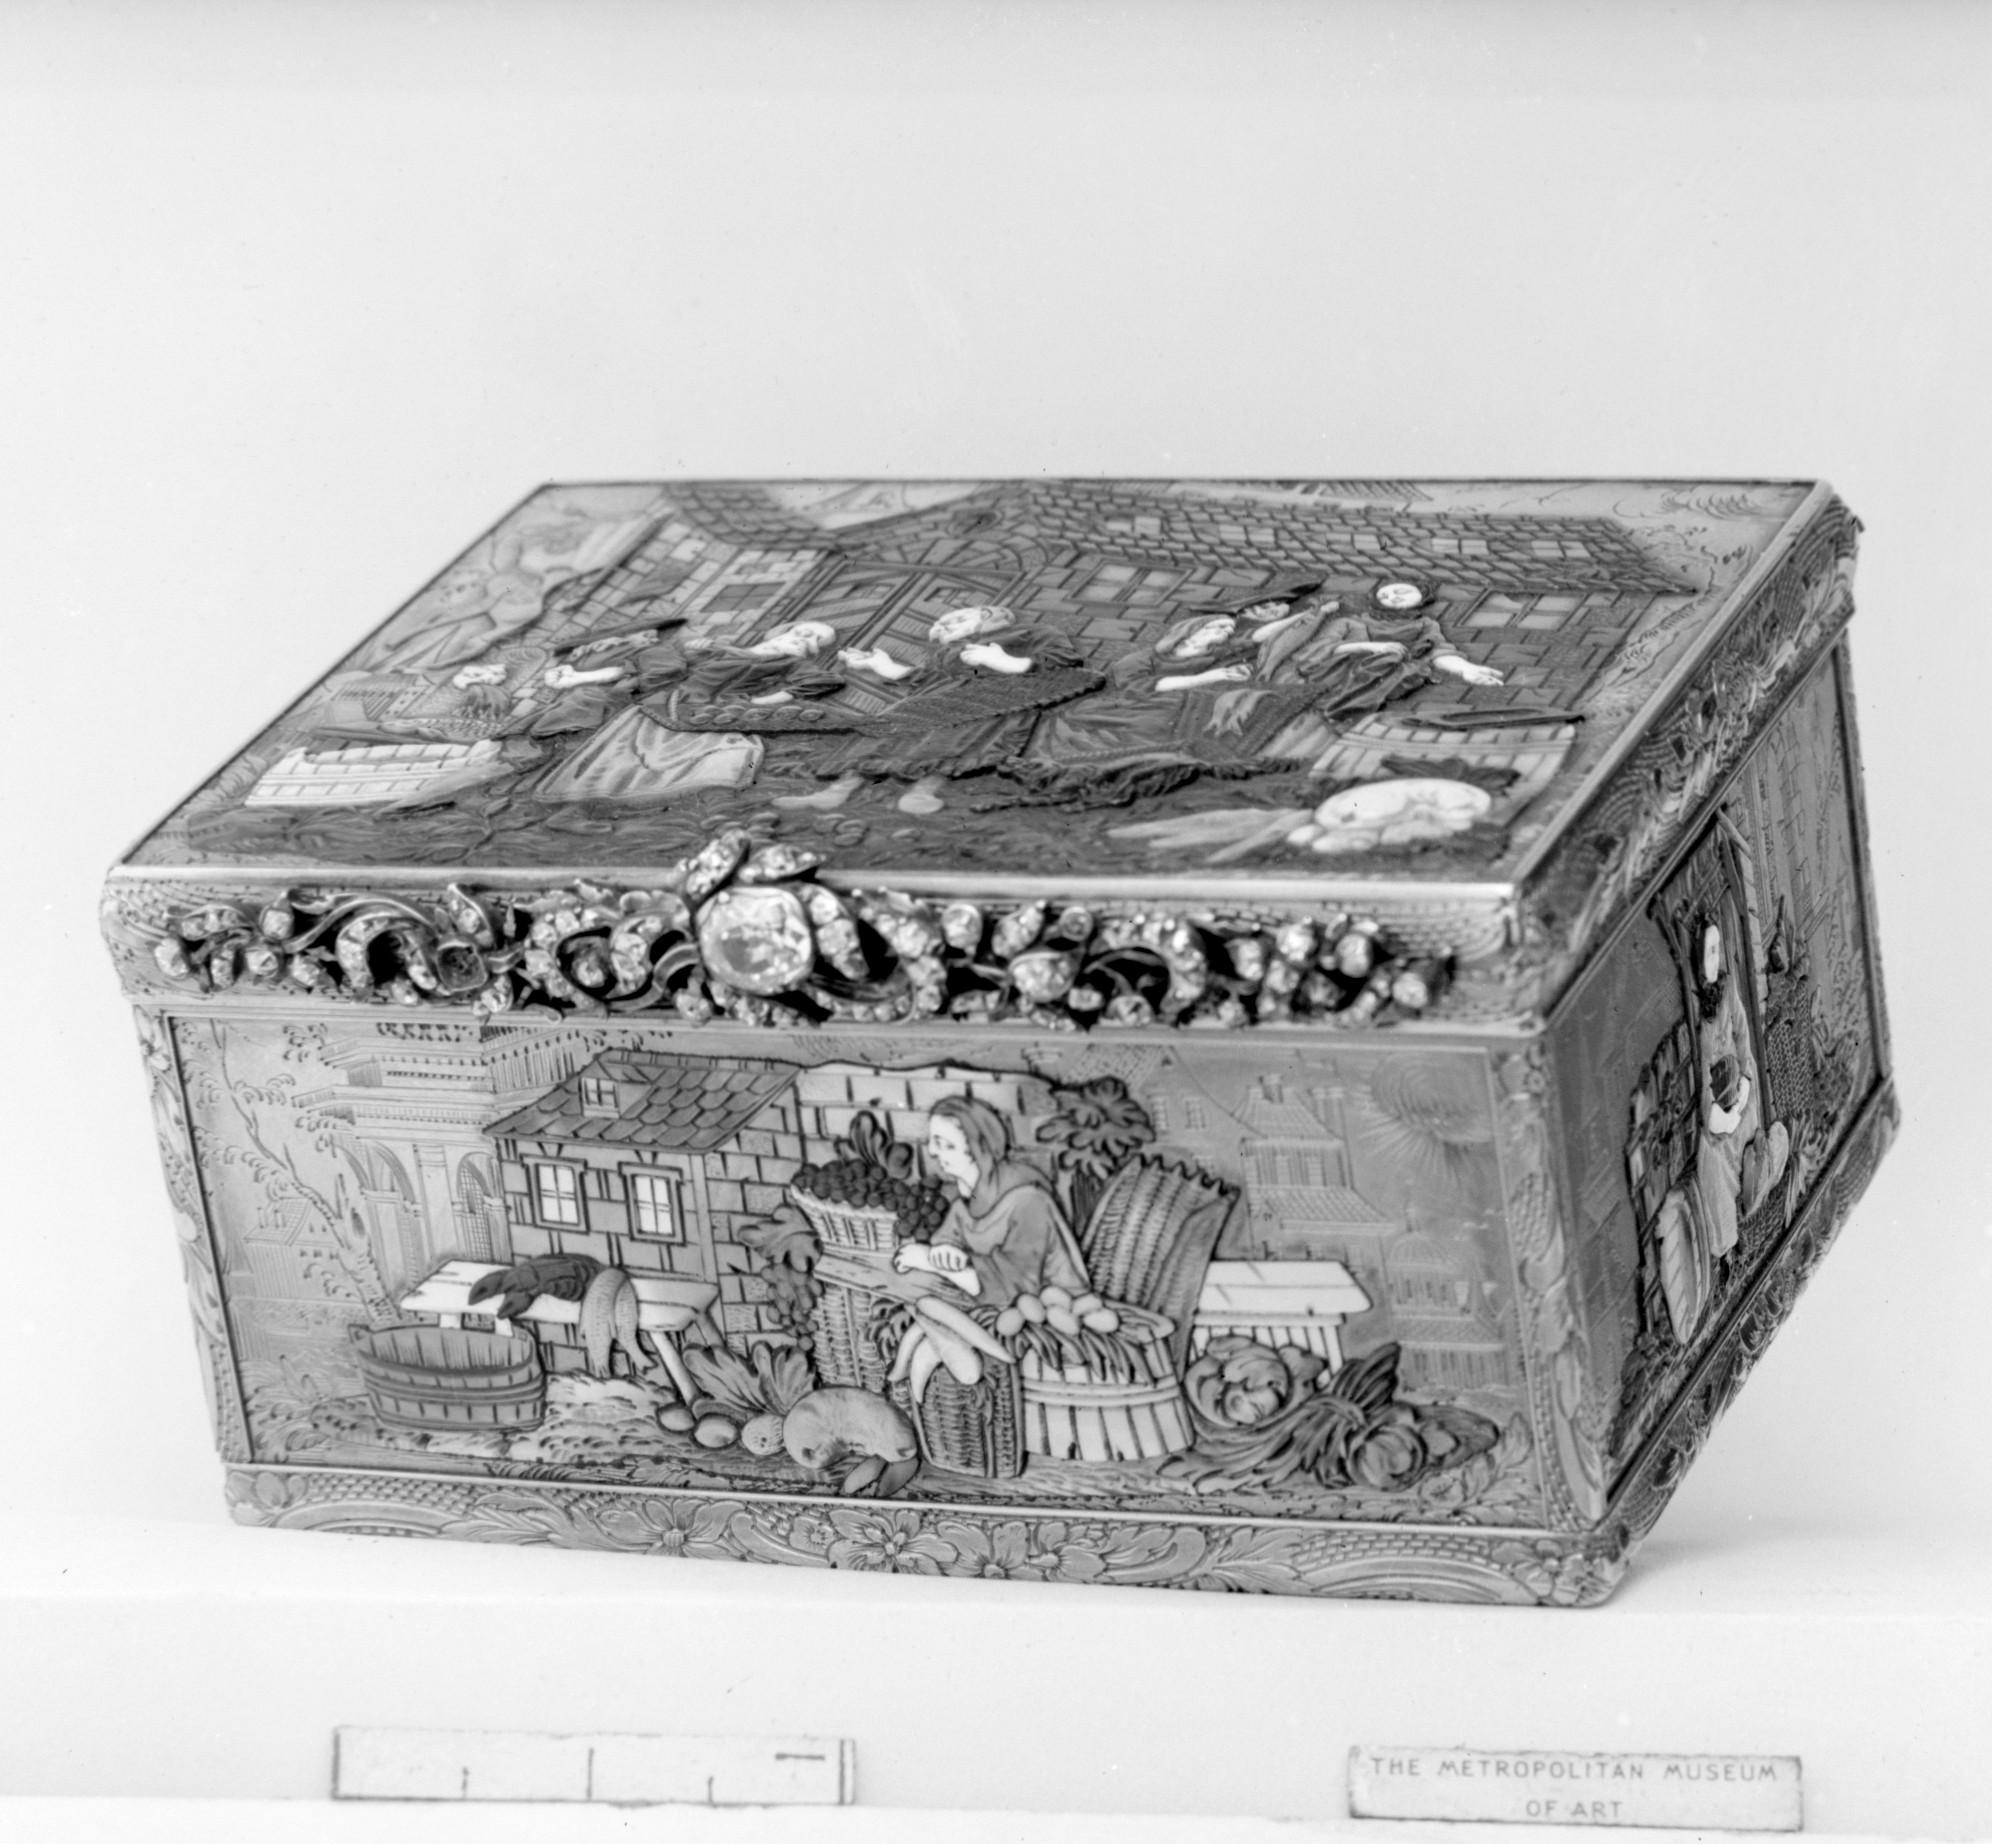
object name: snuffbox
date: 1751-1775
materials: diamond, gold, ivory, mother of pearl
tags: houses,fruit,men,women